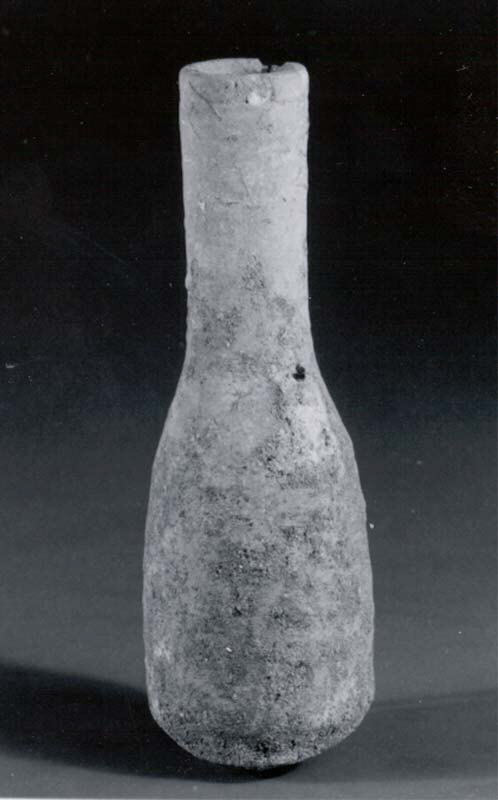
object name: vessel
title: Unguentarium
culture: nabataean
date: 1-100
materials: ceramic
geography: levant